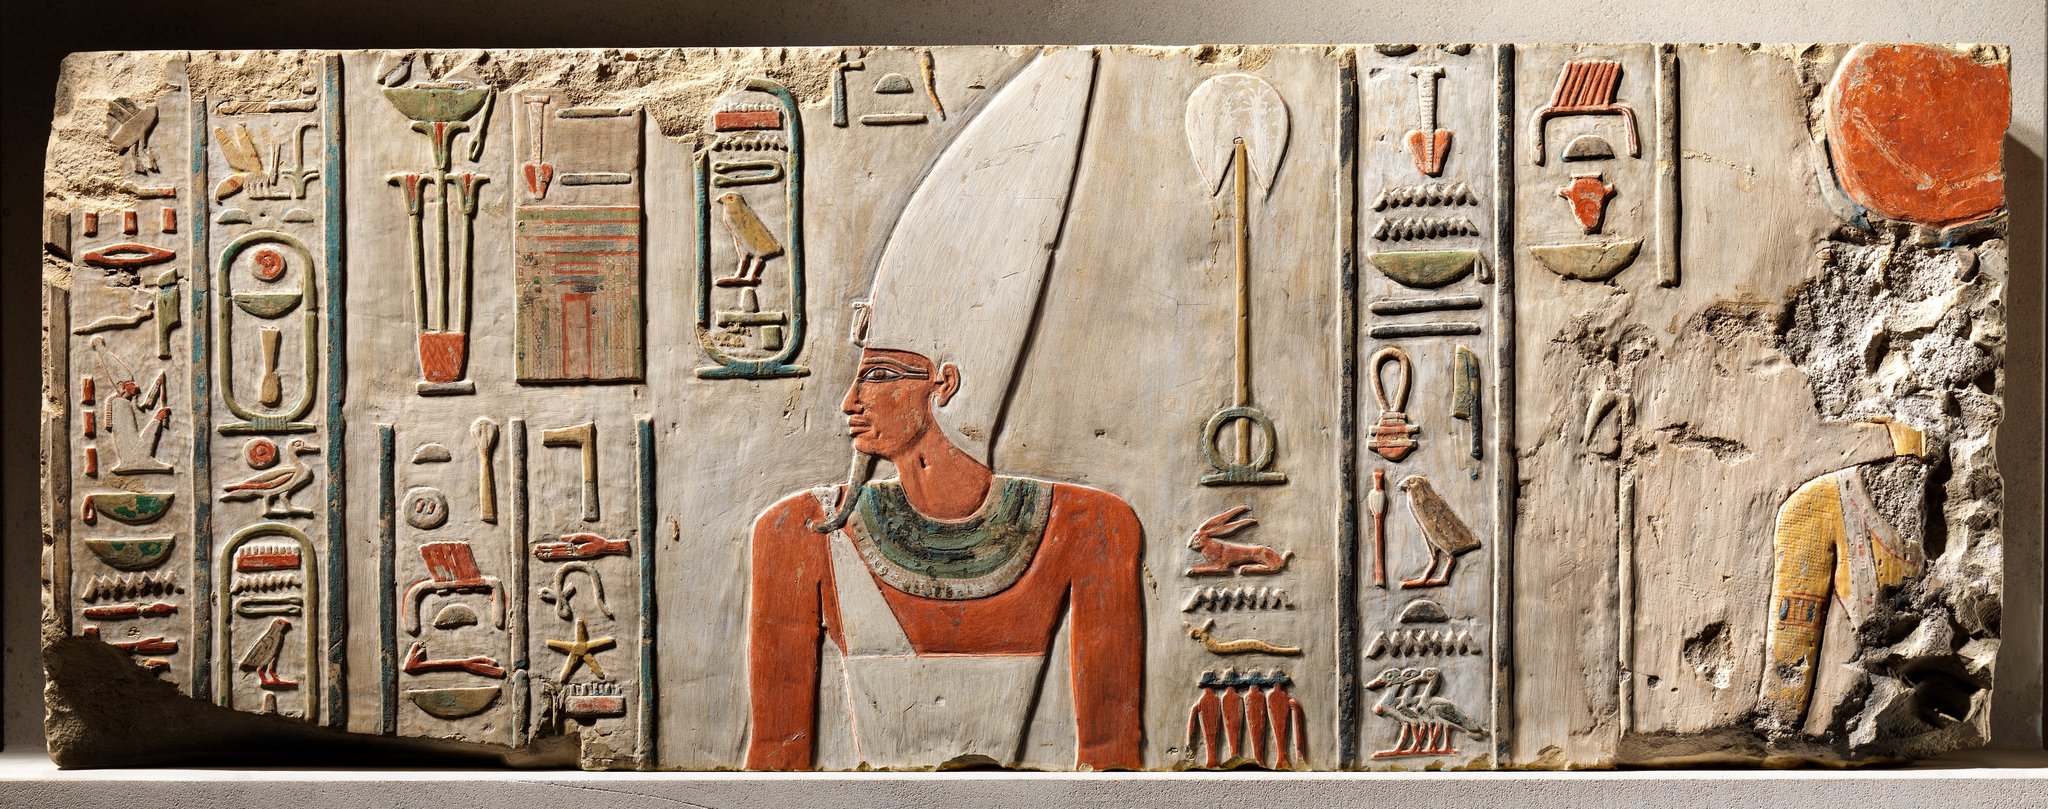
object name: relief, temple wall, mentuhotep ii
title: Relief of Nebhepetre Mentuhotep II and the Goddess Hathor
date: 2010-2000 BCE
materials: limestone, paint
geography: egypt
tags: kings,hieroglyphs,hathor